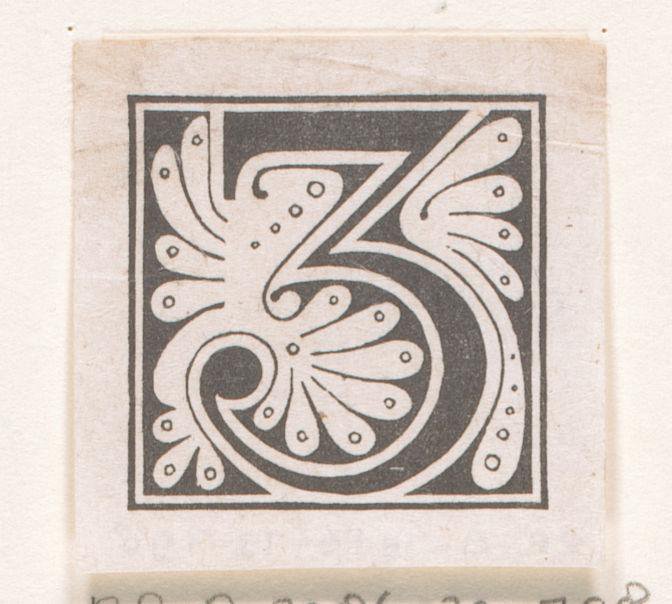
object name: photomechanical print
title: Getal 3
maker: reinier willem petrus de vries (1874-1953)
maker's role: draughtsman, print maker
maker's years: 1874-1953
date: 1904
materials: paper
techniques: printing block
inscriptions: collector's mark: ‘R:MVS.’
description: Het getal is gebruikt voor: Veth, Jan. Jozef Israëls en zijn kunst. Arnhem en Nijmegen: Gebroeders E&M Cohen, 1904.